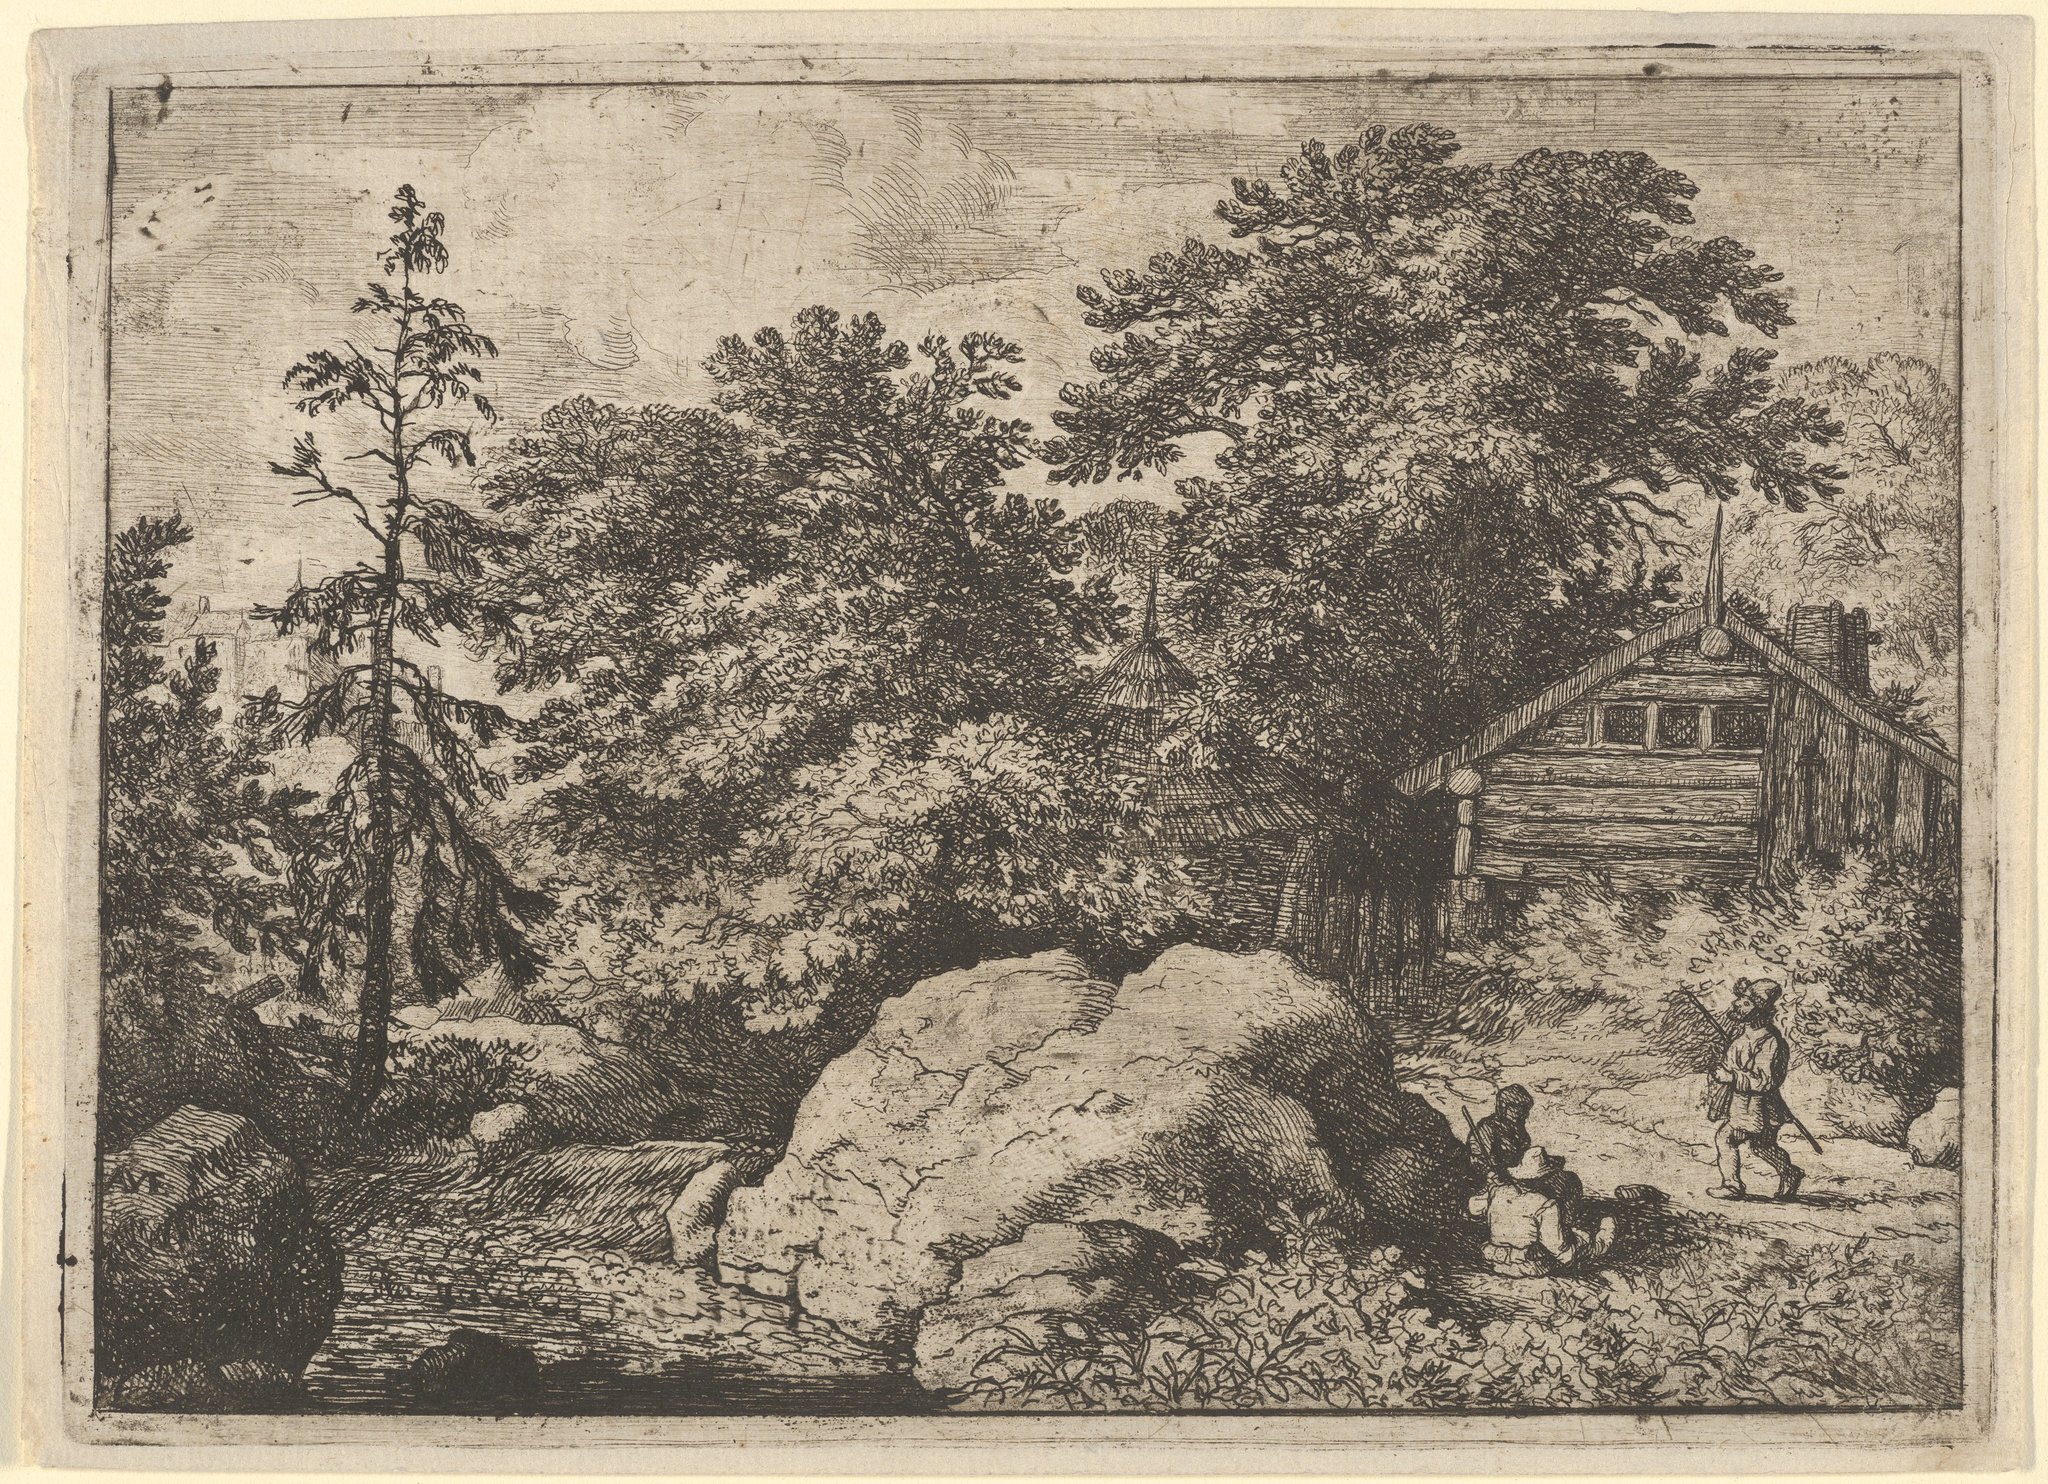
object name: print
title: The Hill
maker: allart van everdingen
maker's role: artist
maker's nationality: dutch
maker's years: 1621-1675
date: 1621-1675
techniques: engraving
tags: landscapes